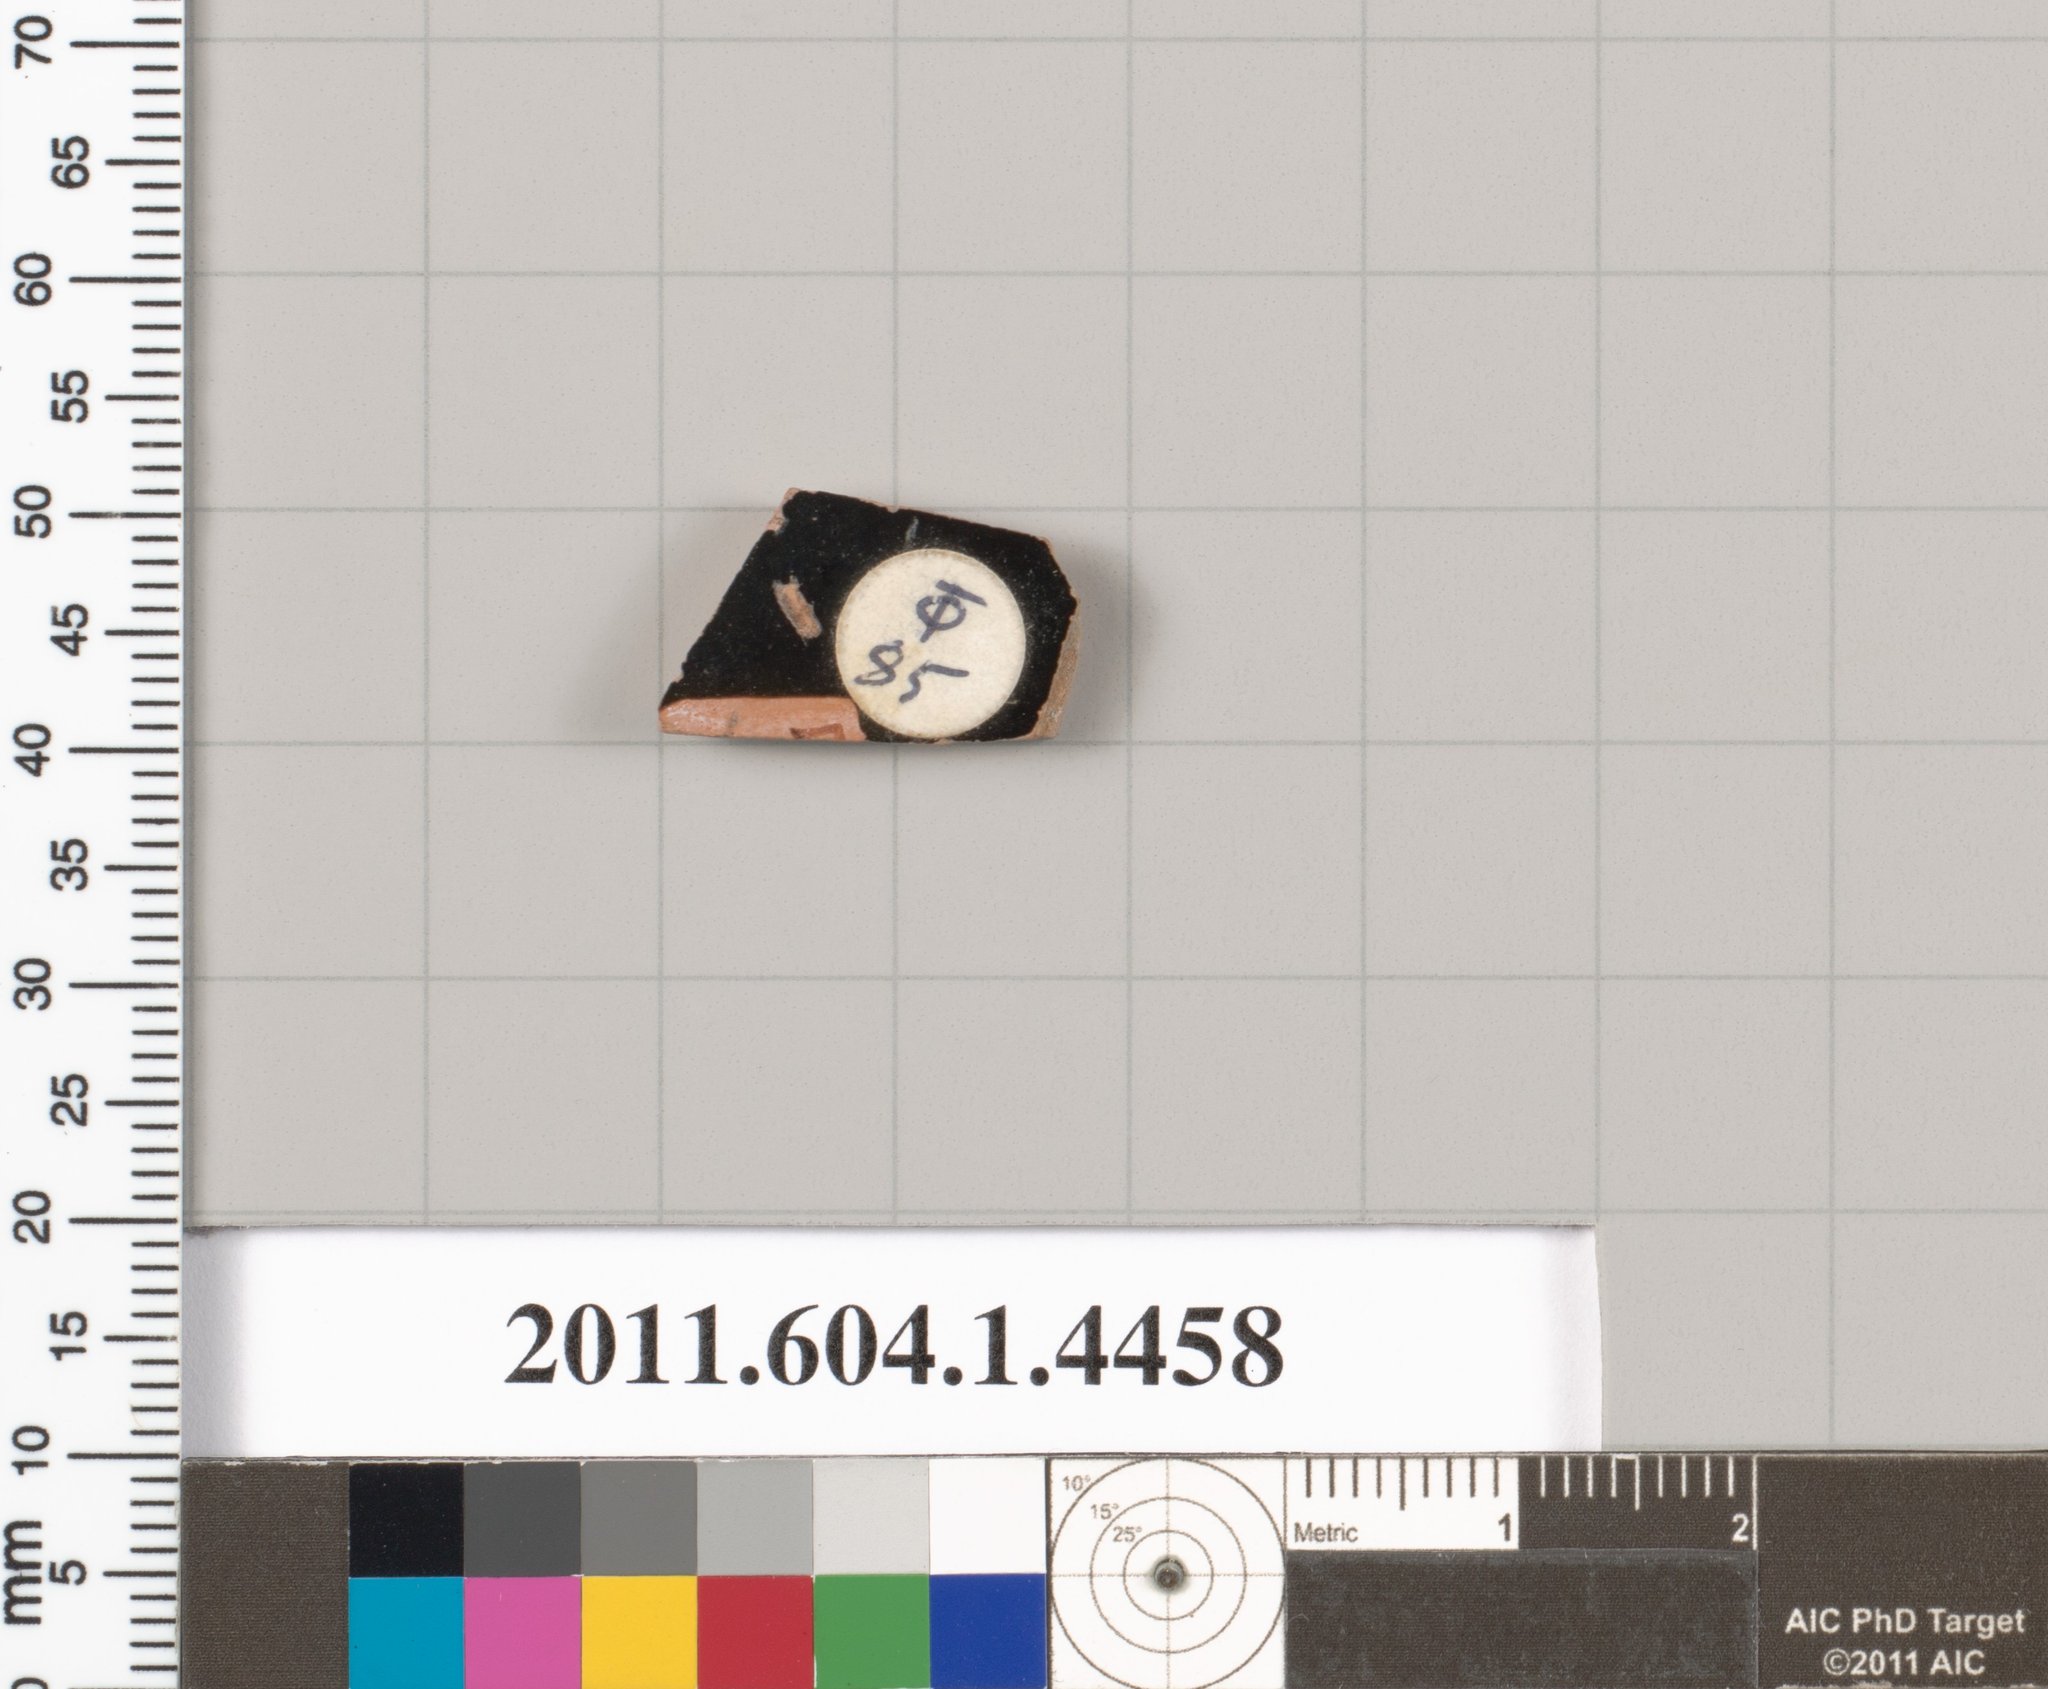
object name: kylix fragment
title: Terracotta fragment of a kylix (drinking cup)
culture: greek, attic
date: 475-451 BCE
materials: terracotta